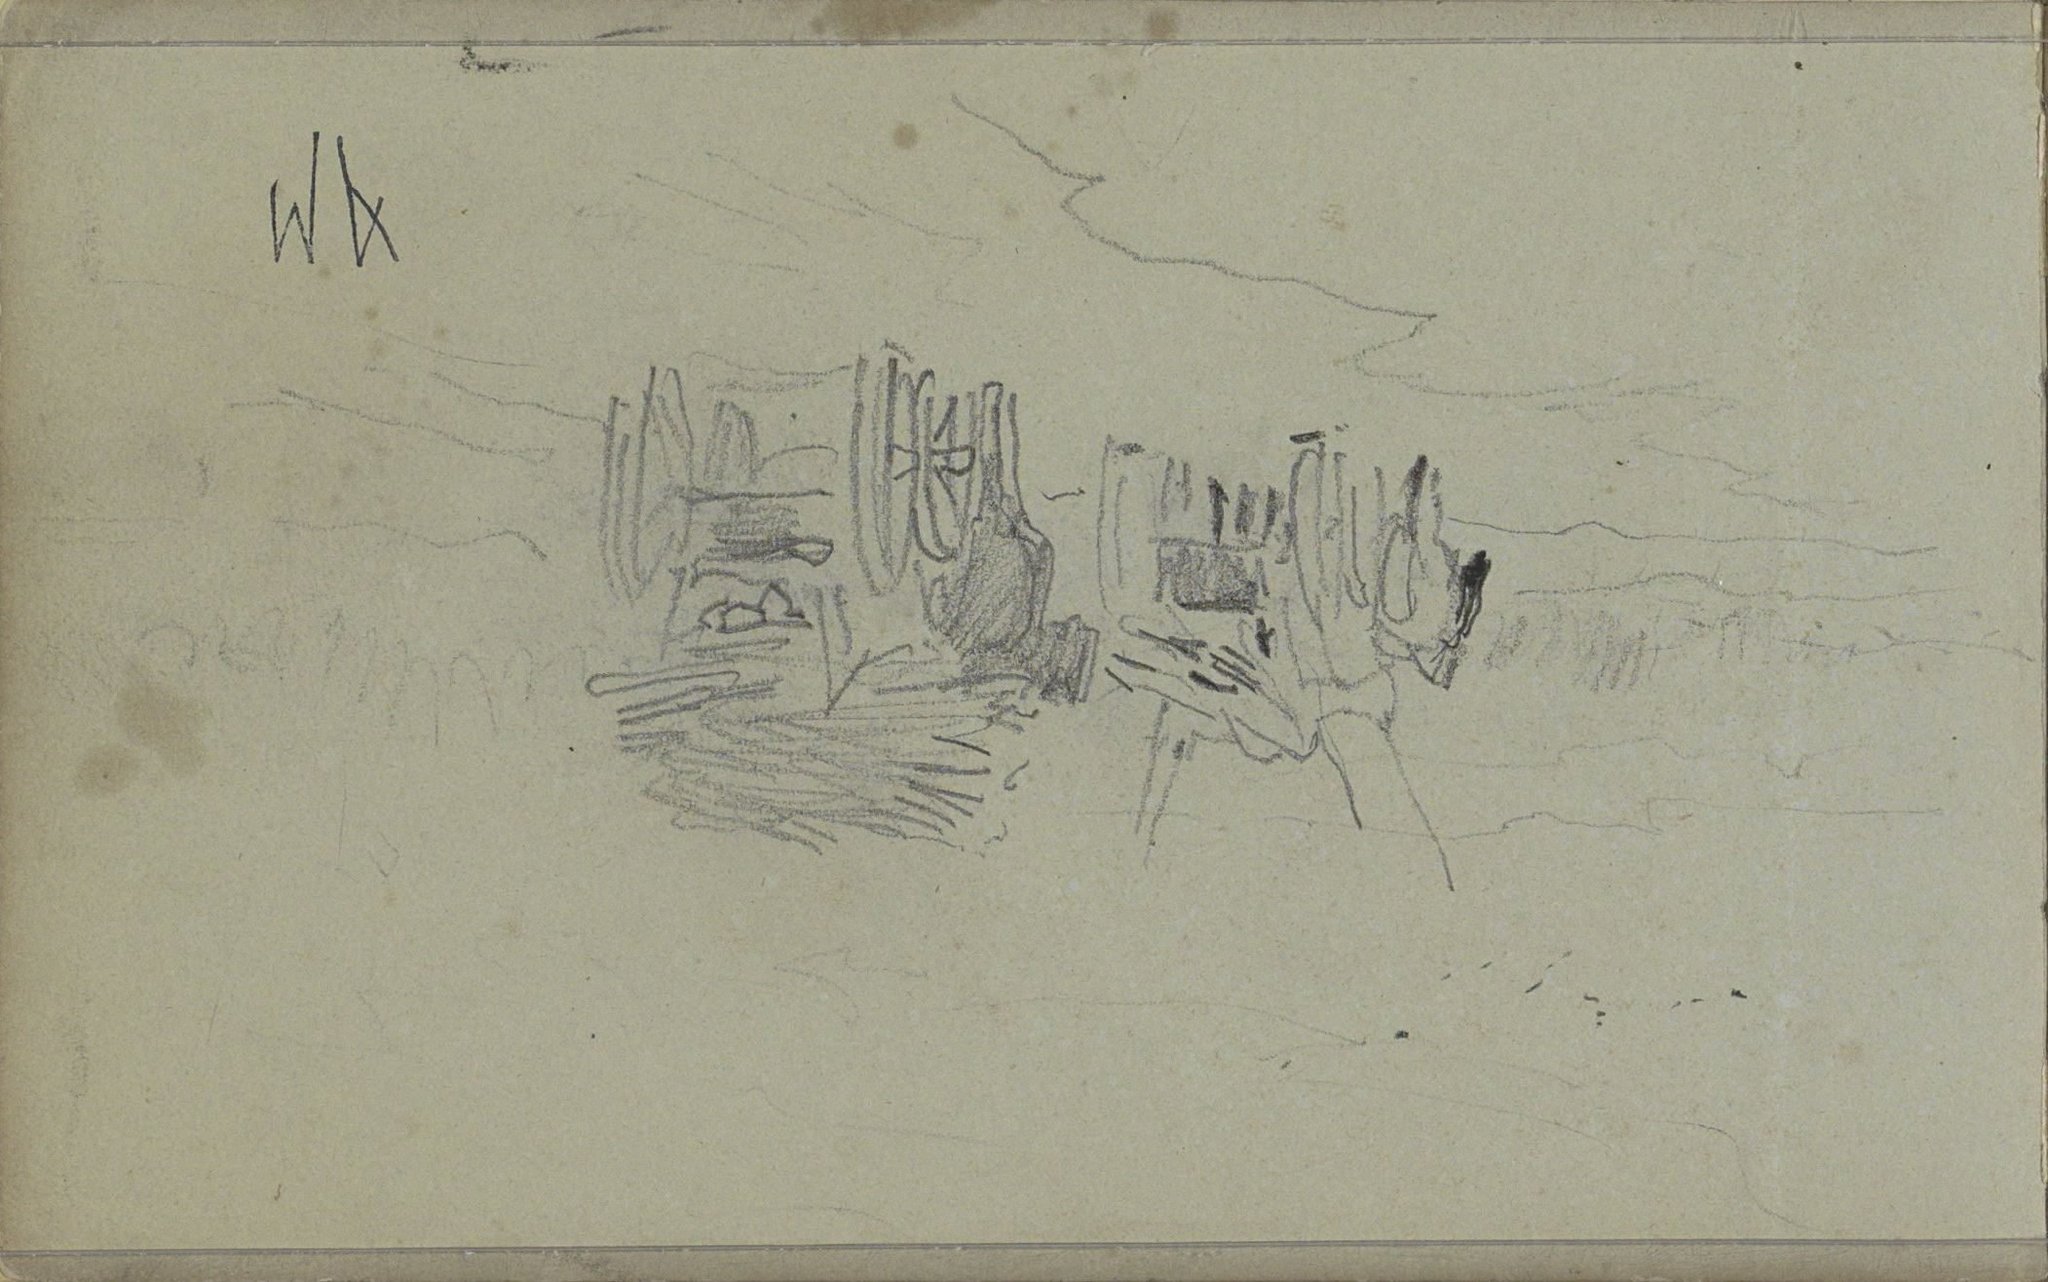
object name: sketchbook leaf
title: Twee met sprokkelhout beladen paardenkarren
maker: anton mauve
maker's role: draughtsman, painter, print maker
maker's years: 1838-1888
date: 1848-1888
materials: paper, pencil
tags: trees (+ branch, stick), (farm) wagon, freight wagon, cart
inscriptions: monogram: ‘AM’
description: Blad 39 verso uit een schetsboek met 44 bladen.